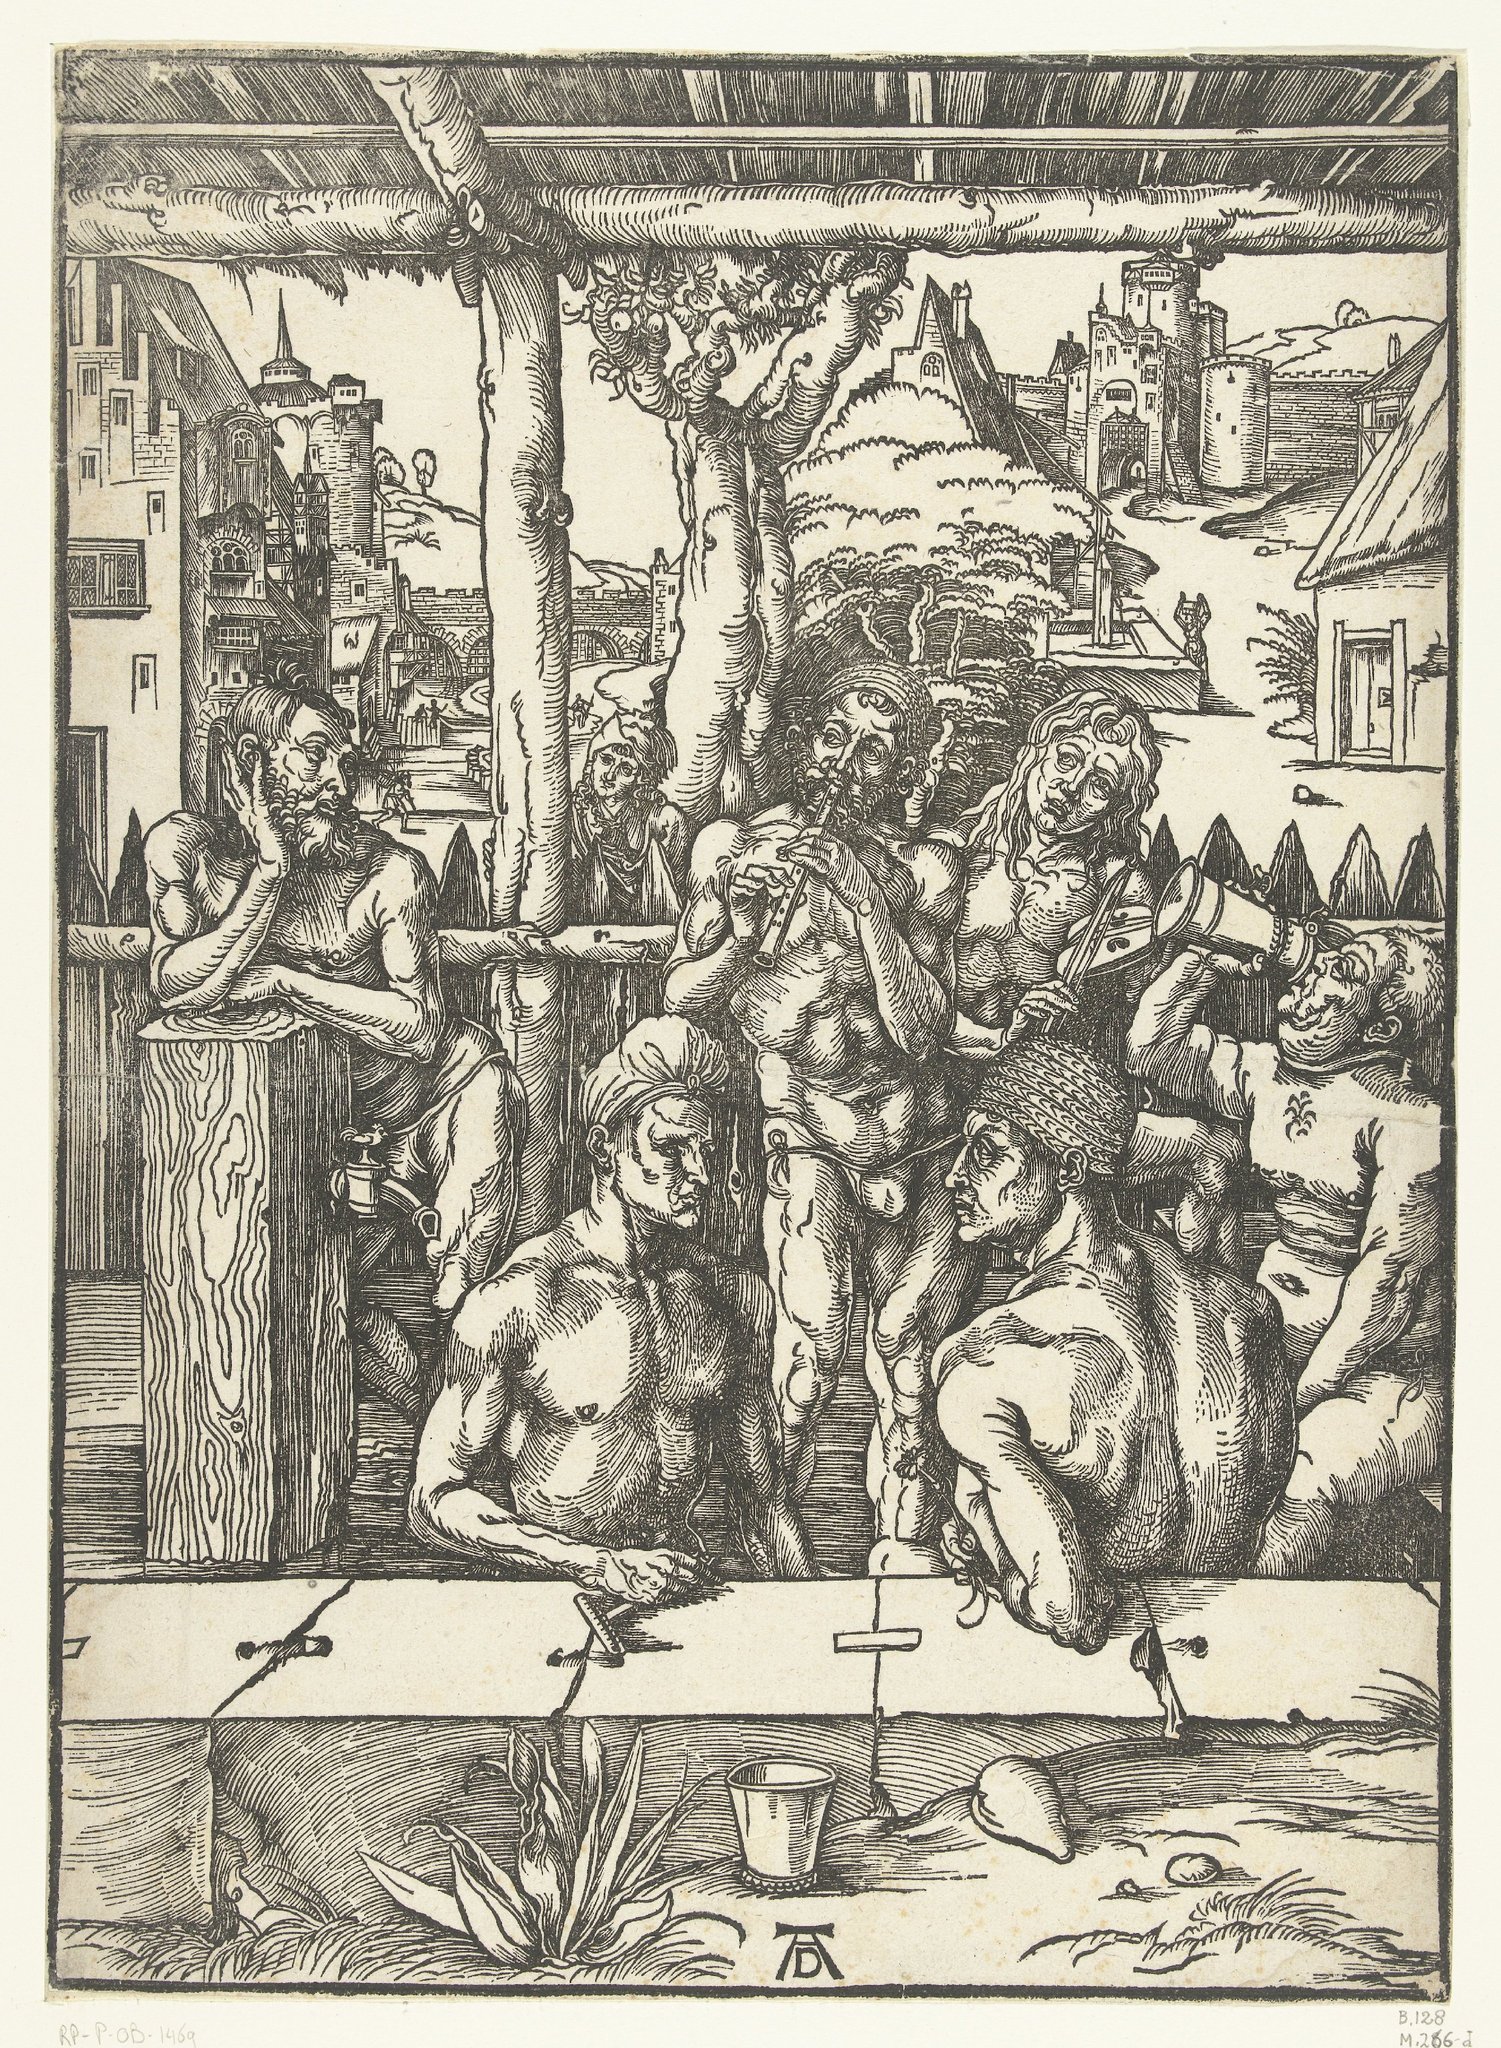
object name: print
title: Het mannenbad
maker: albrecht dürer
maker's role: draughtsman, painter, print maker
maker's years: 1471-1528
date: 1496-1497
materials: paper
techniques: woodcut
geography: nuremberg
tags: public baths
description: Zes mannen, elk met slechts een klein onderbroekje aan, praten, drinken en musiceren onder een overhuiving bij een kraan.